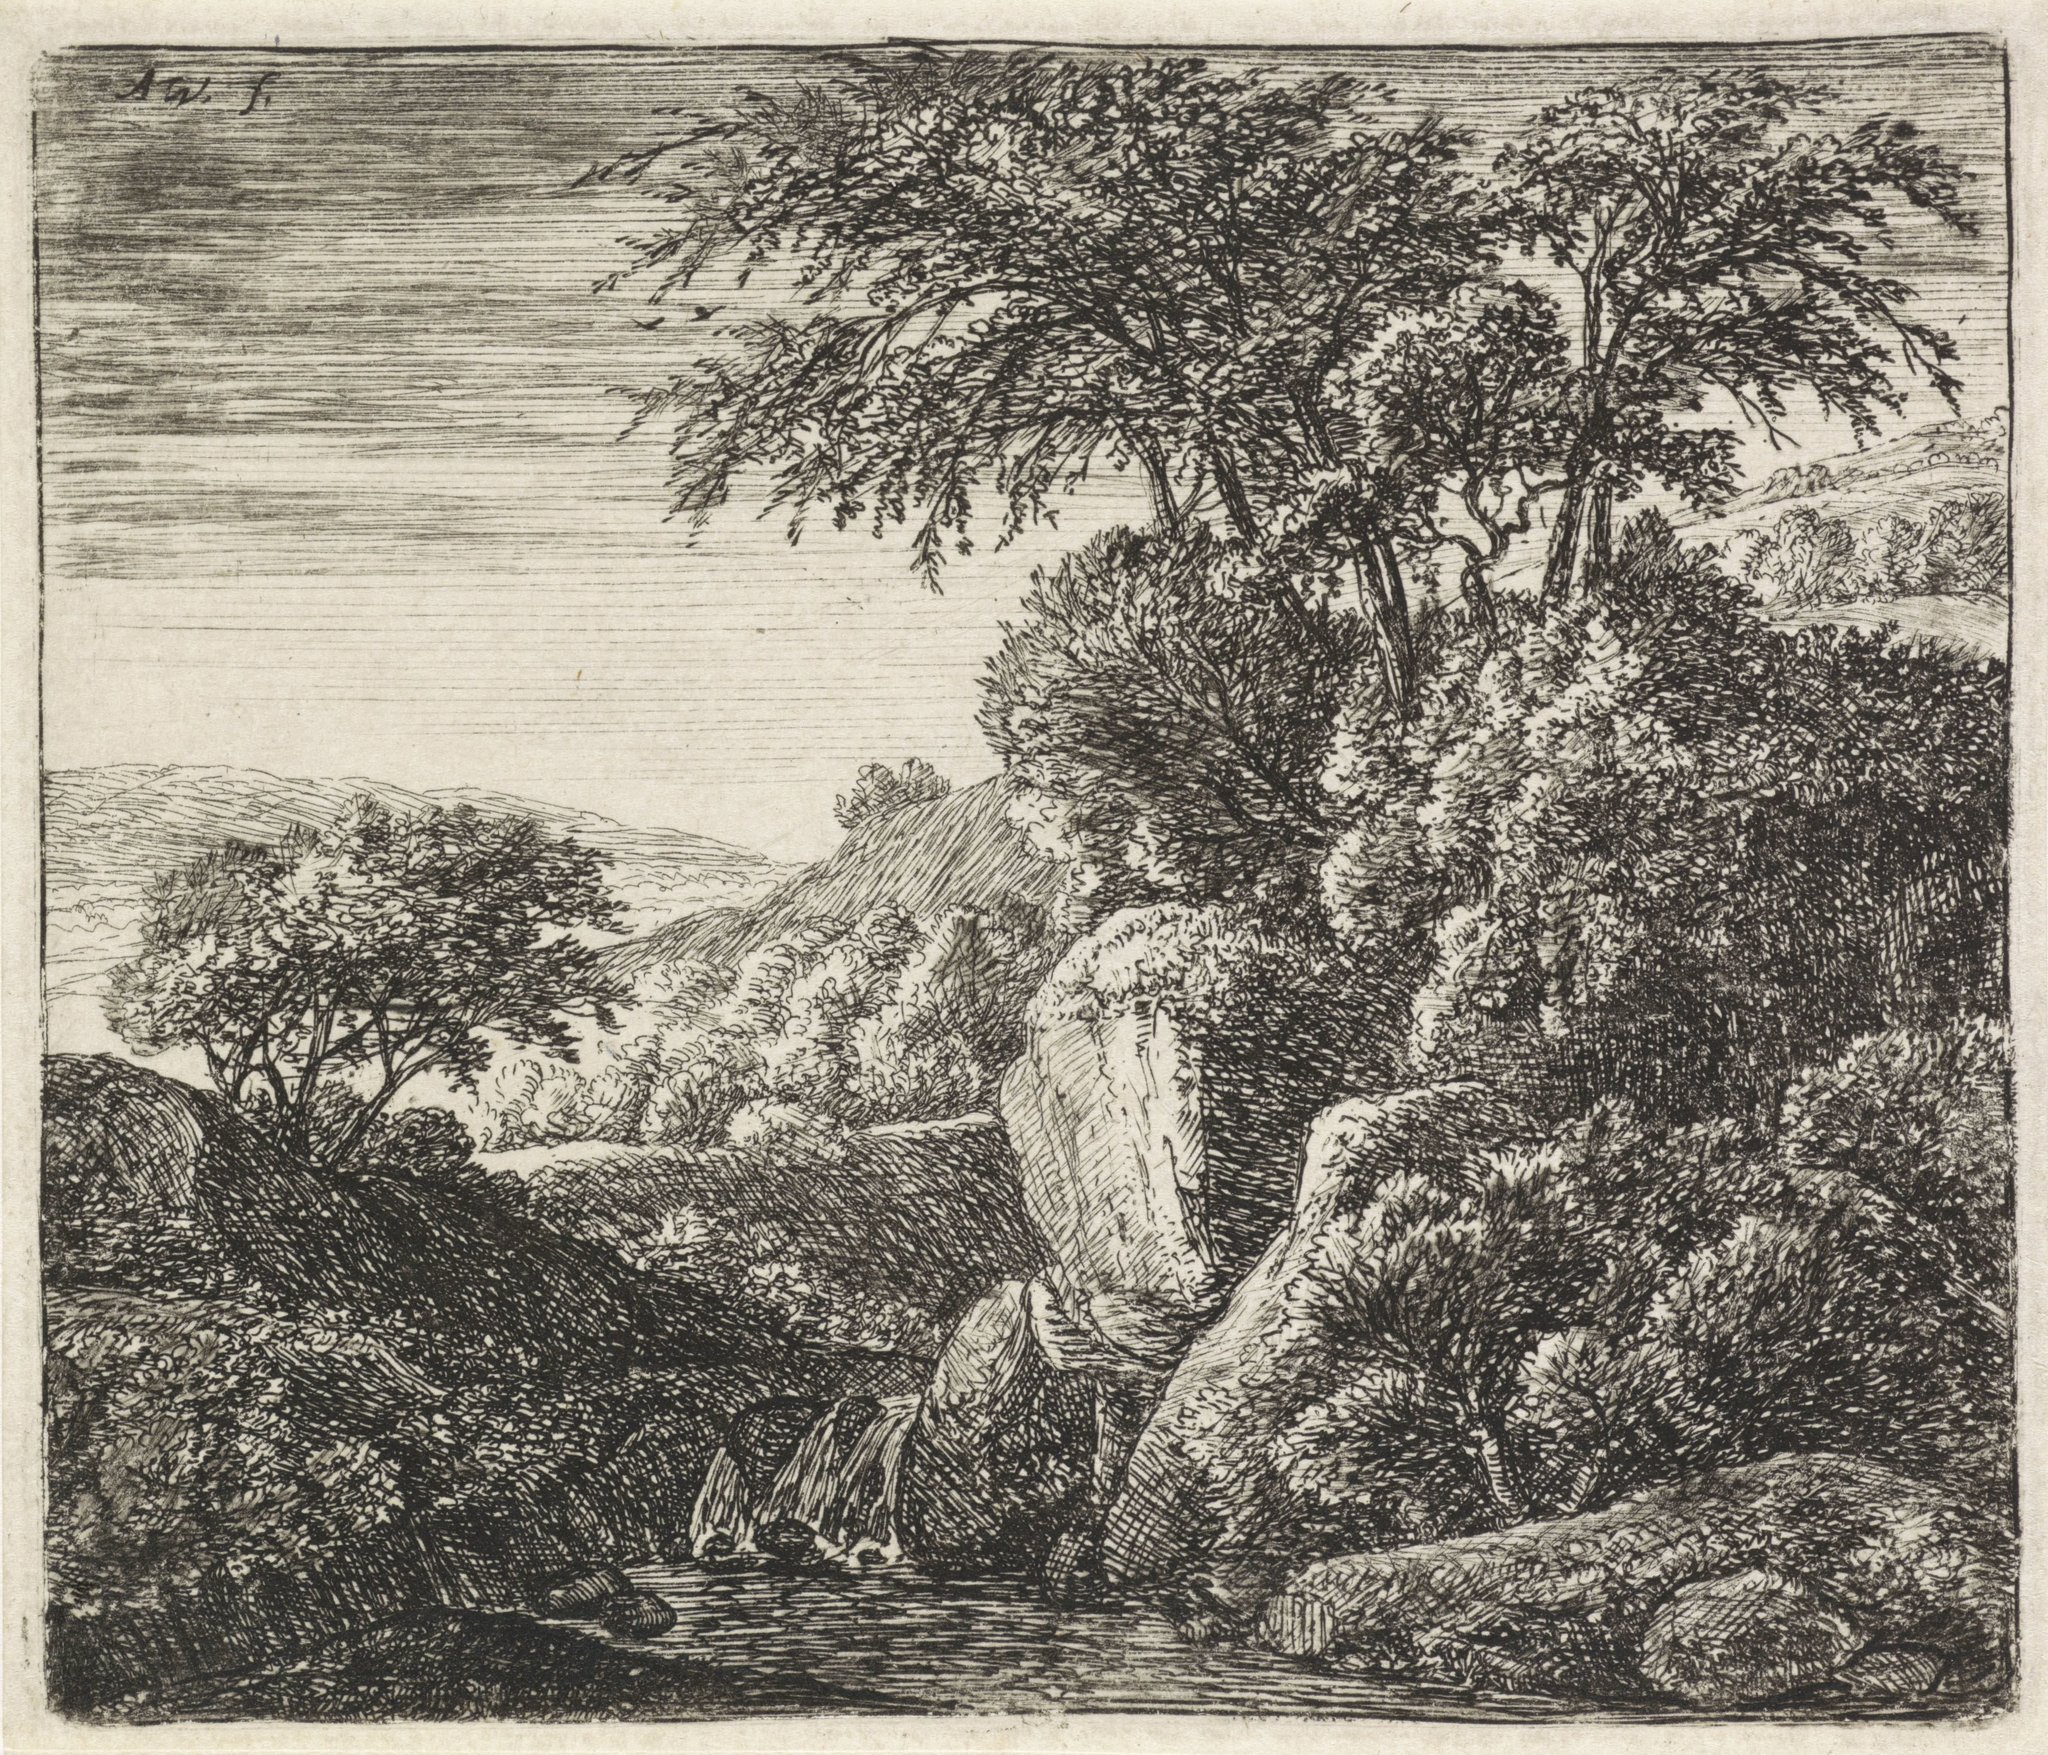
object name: print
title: Rotsachtige landschappen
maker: anthonie waterloo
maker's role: draughtsman, painter, print maker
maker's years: 1609-1690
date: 1630-1663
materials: paper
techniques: etching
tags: waterfall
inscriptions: collector's mark: Lugt 240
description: Heuvelachtig landschap met rechts een met bomen begroeide rotspartij en een kleine waterval die in een meer uitkomt.